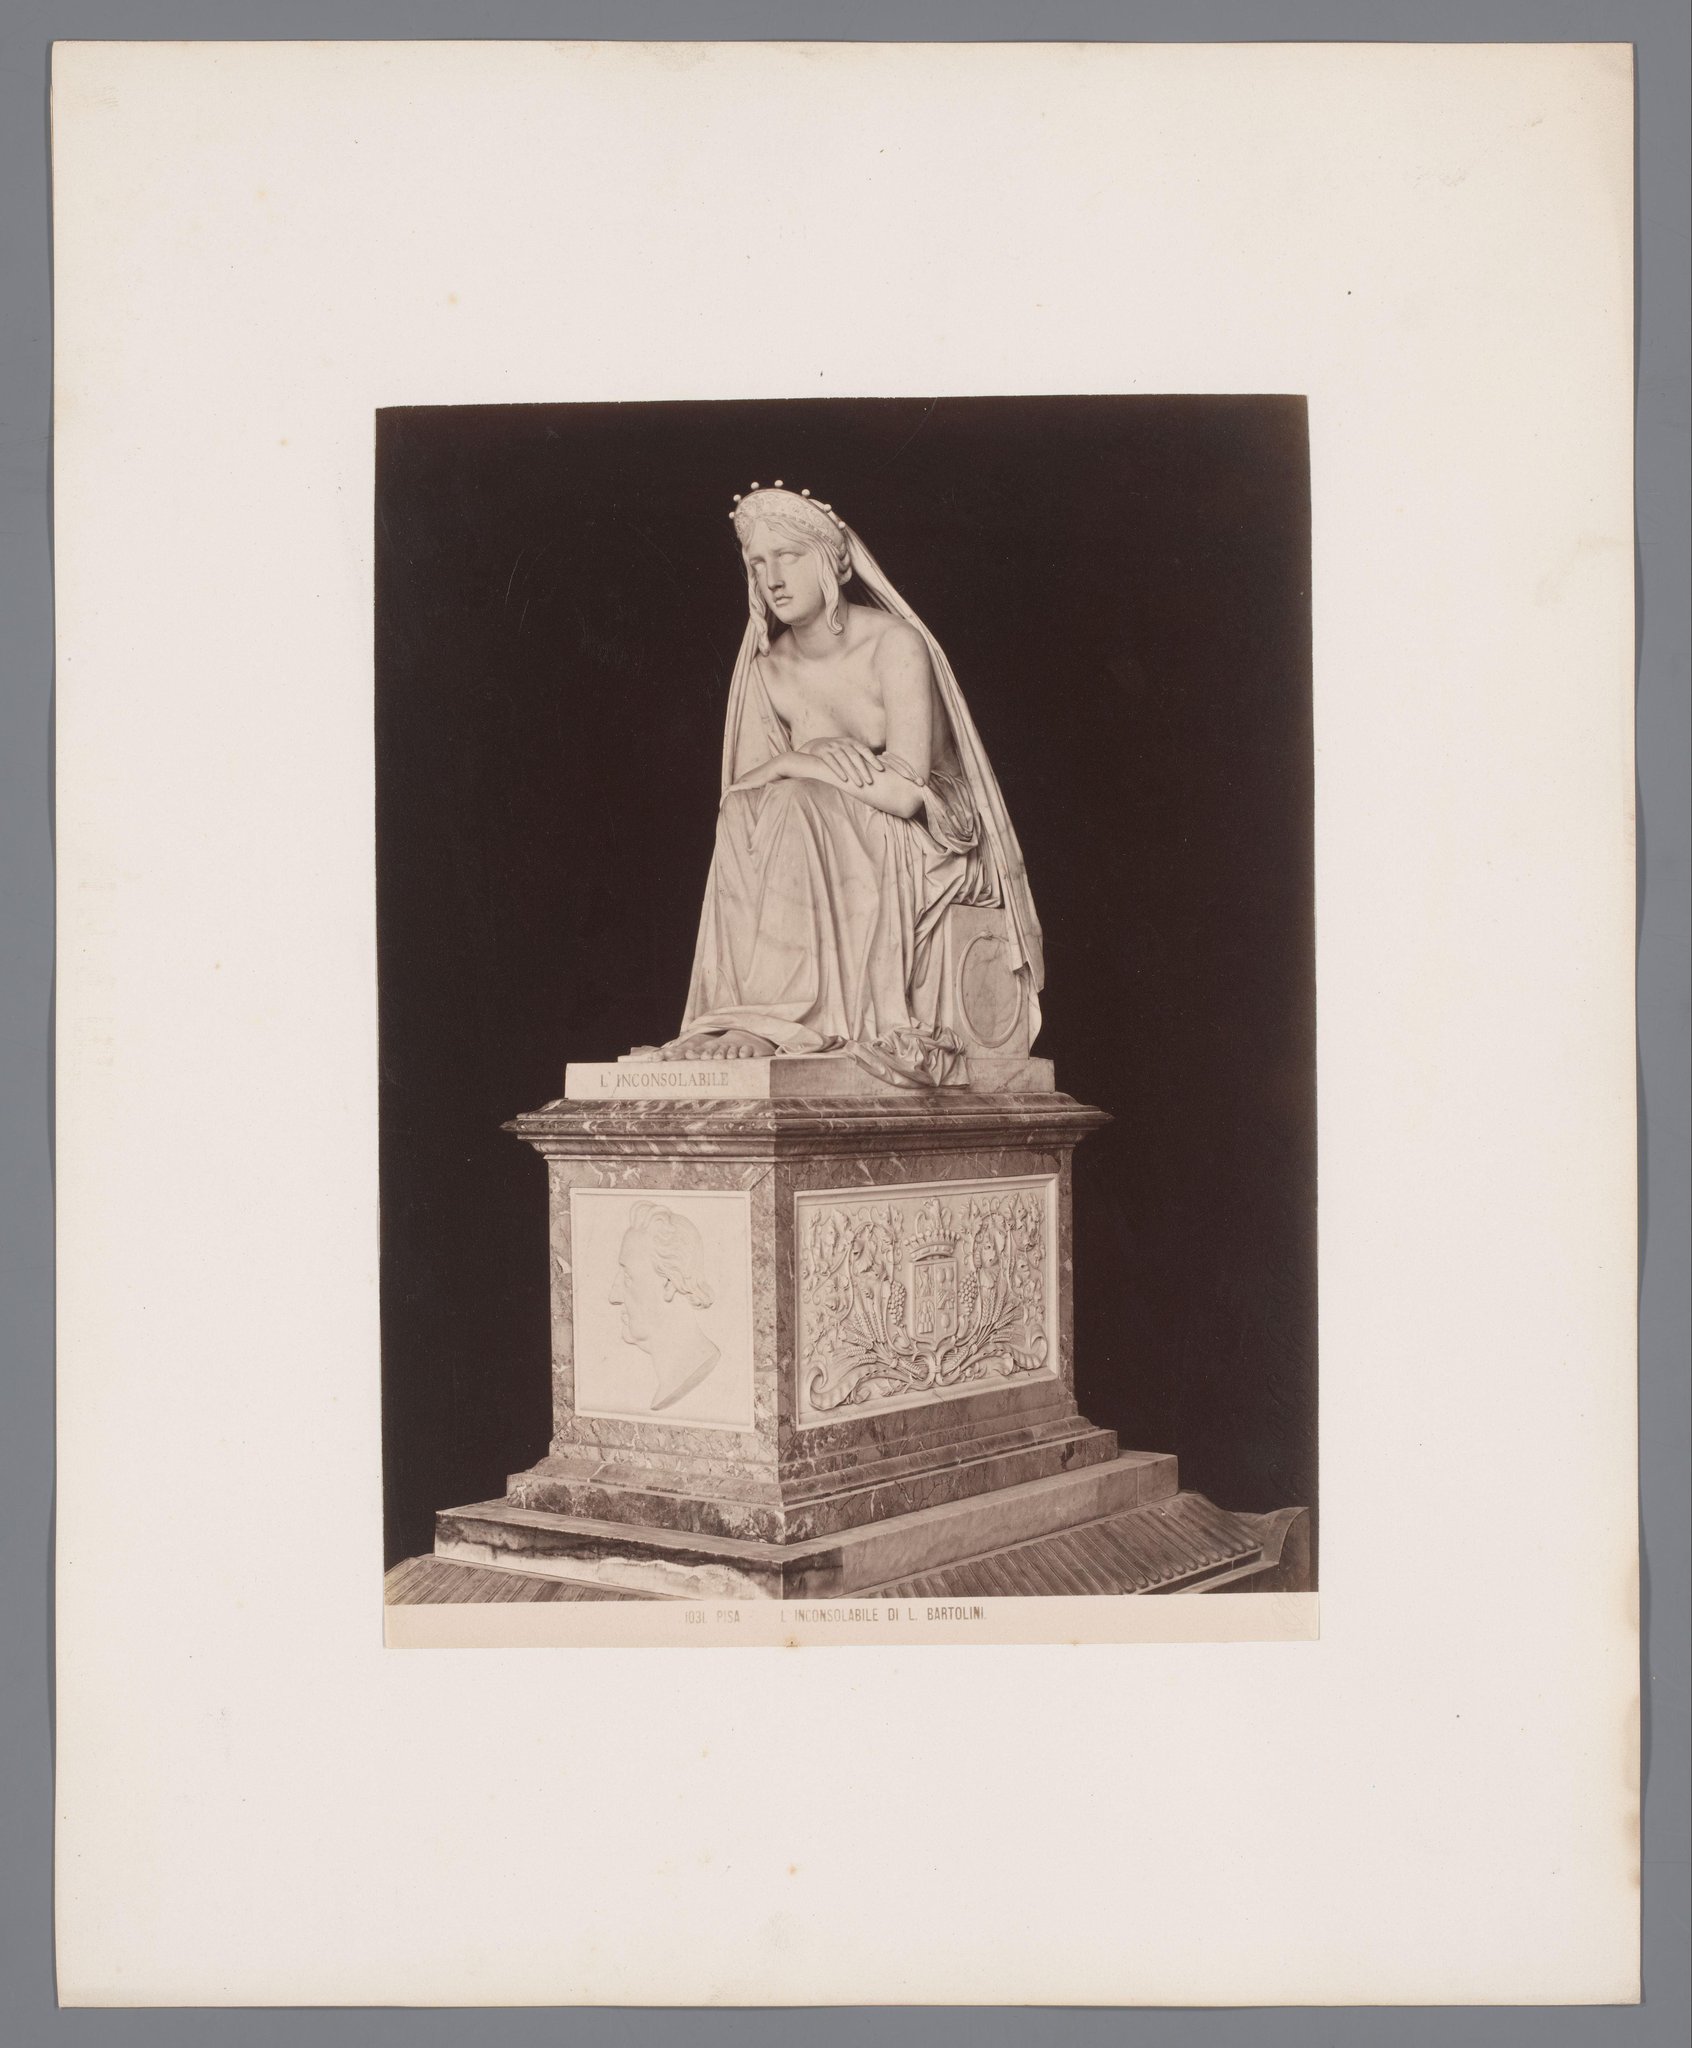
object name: photograph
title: Pisa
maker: b. f. rives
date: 1851-1900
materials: cardboard, paper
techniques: albumen print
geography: pisa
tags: piece of sculpture, reproduction of a piece of sculpture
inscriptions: number: ‘1031.’, inscription: ‘B F H Rives’